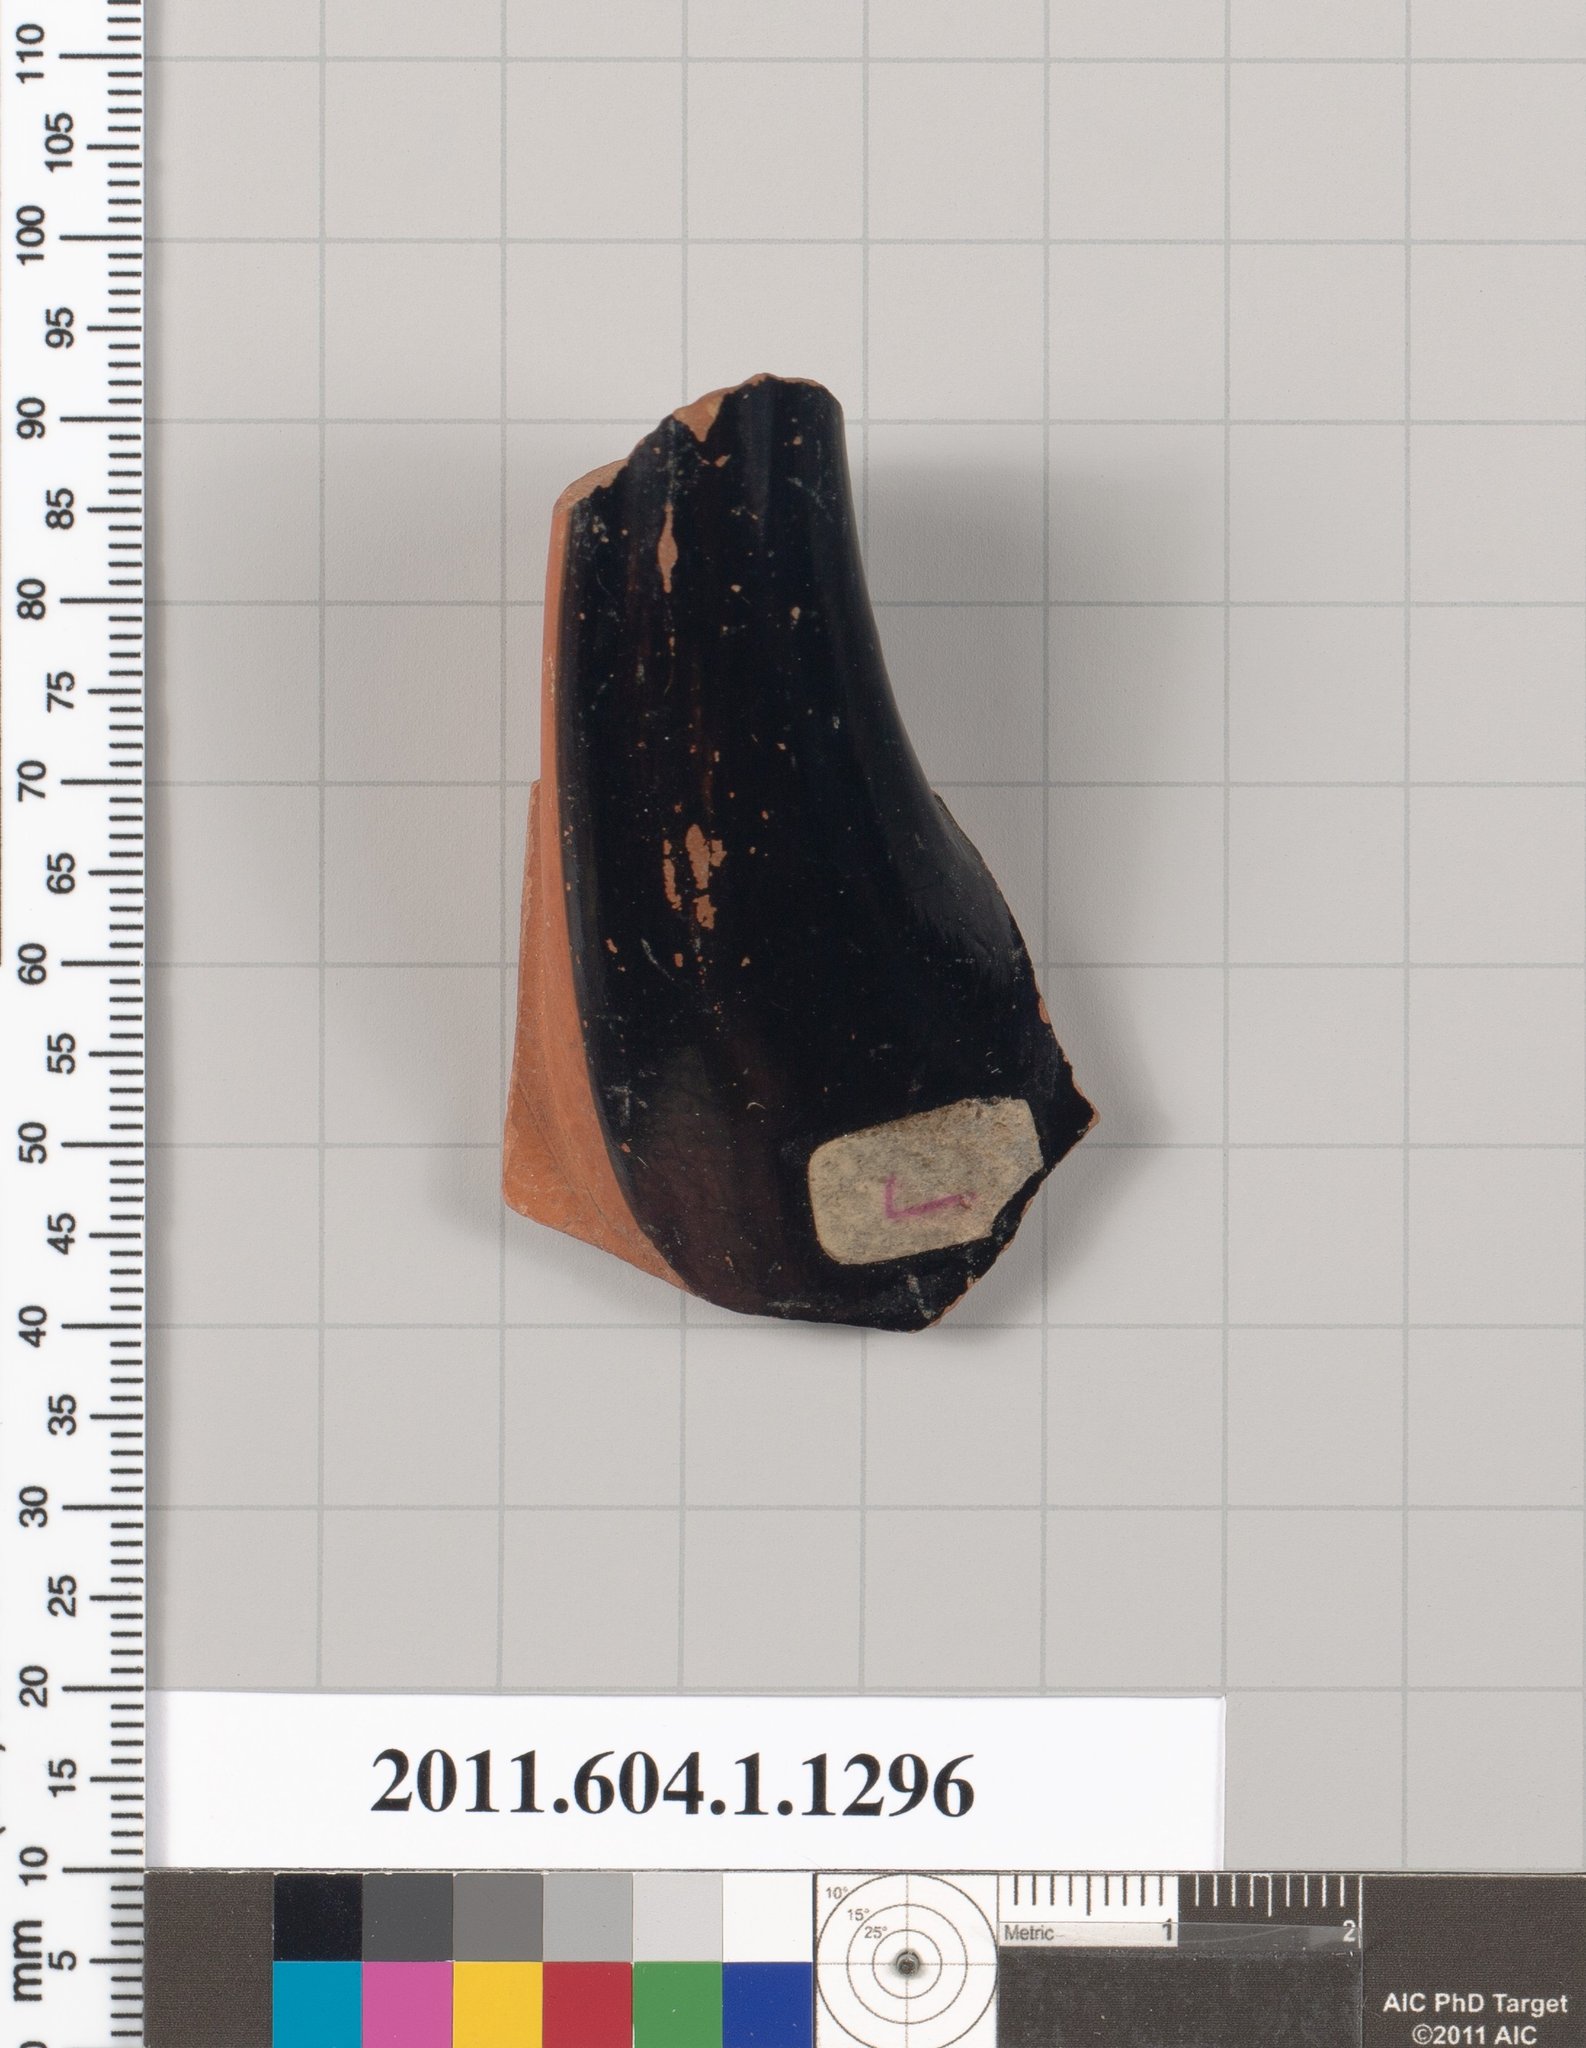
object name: kylix fragment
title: Terracotta fragment of a kylix (drinking cup)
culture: greek, attic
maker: panaitios painter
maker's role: artist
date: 500-480 BCE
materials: terracotta